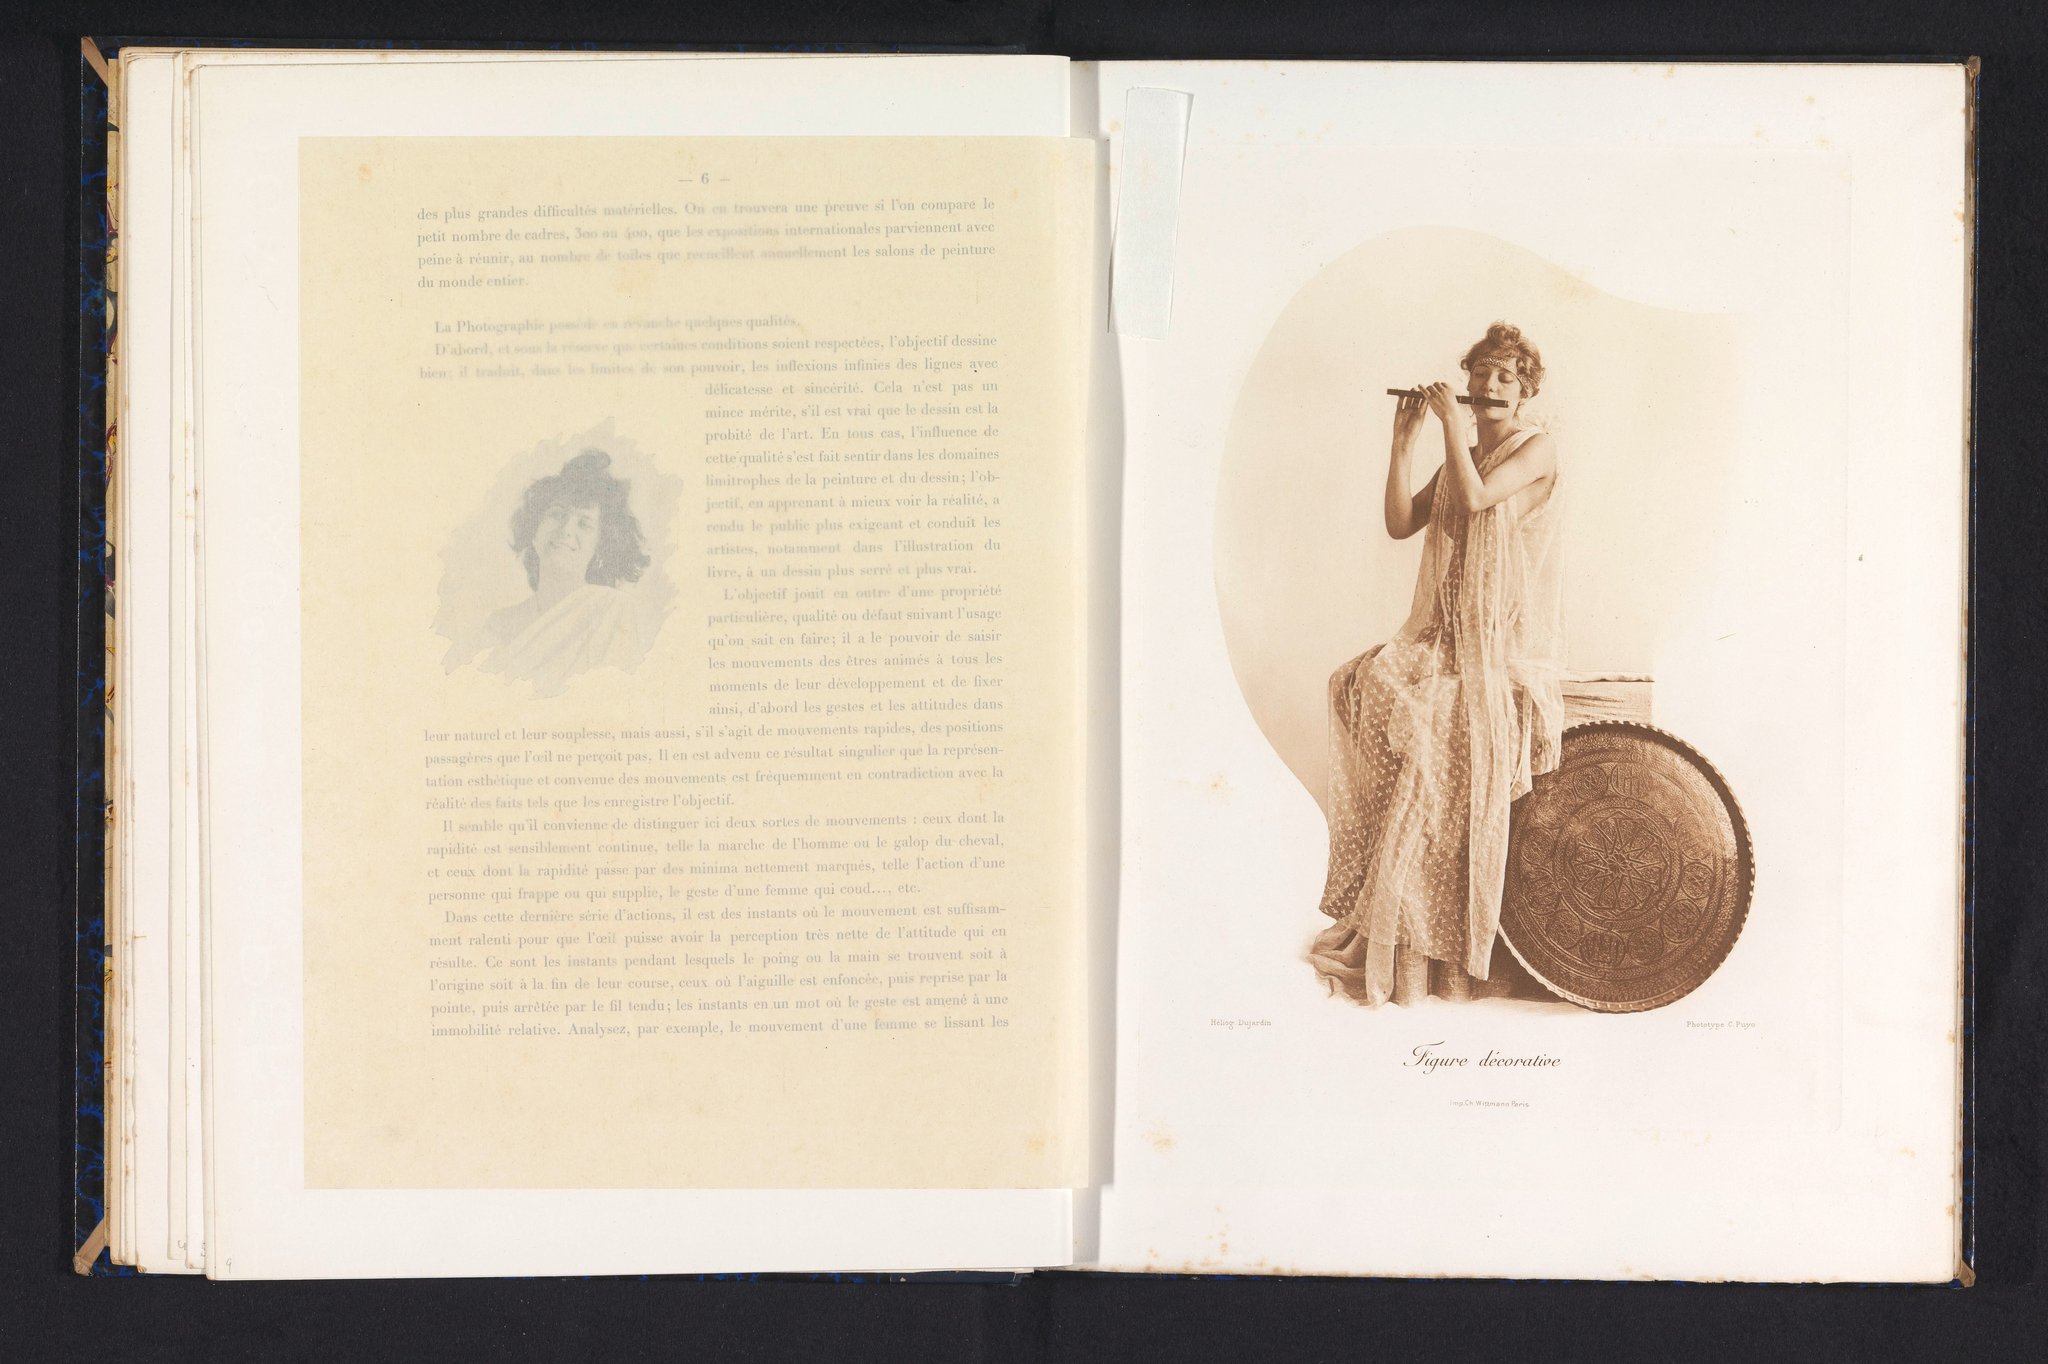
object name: page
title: Dwarsfluit spelende vrouw met een schaal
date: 1886-1896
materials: paper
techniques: photoaquatint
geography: france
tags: serving-dish, platter, adult woman, transverse flute